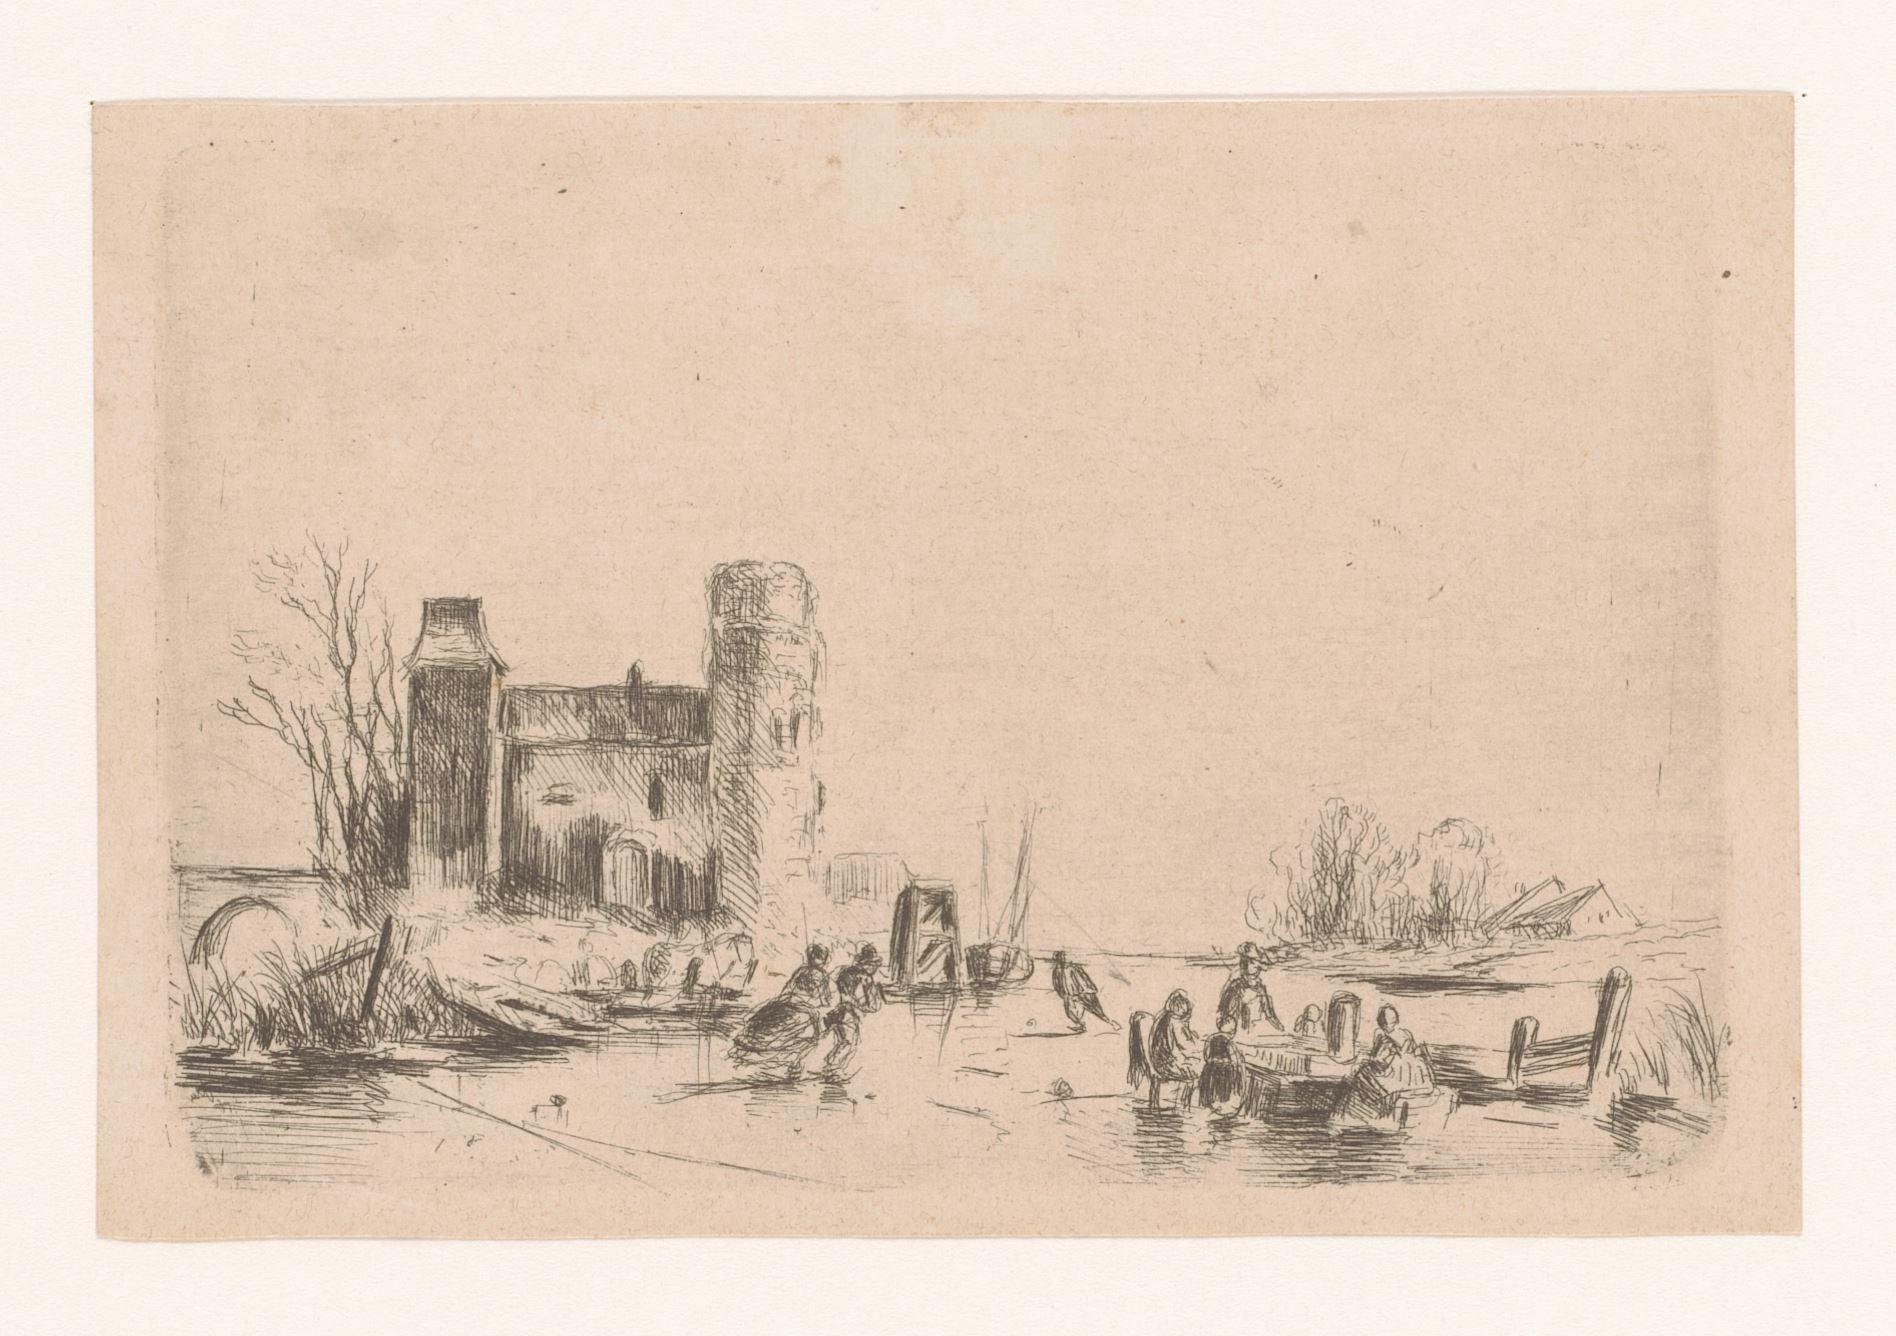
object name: print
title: Schaatsers bij een kasteel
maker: louis smets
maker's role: print maker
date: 1852-1868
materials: paper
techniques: etching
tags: castle, skates (winter sports), ice ~ state of water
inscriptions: collector's mark: Lugt 2228, collector's mark: Lugt 1485